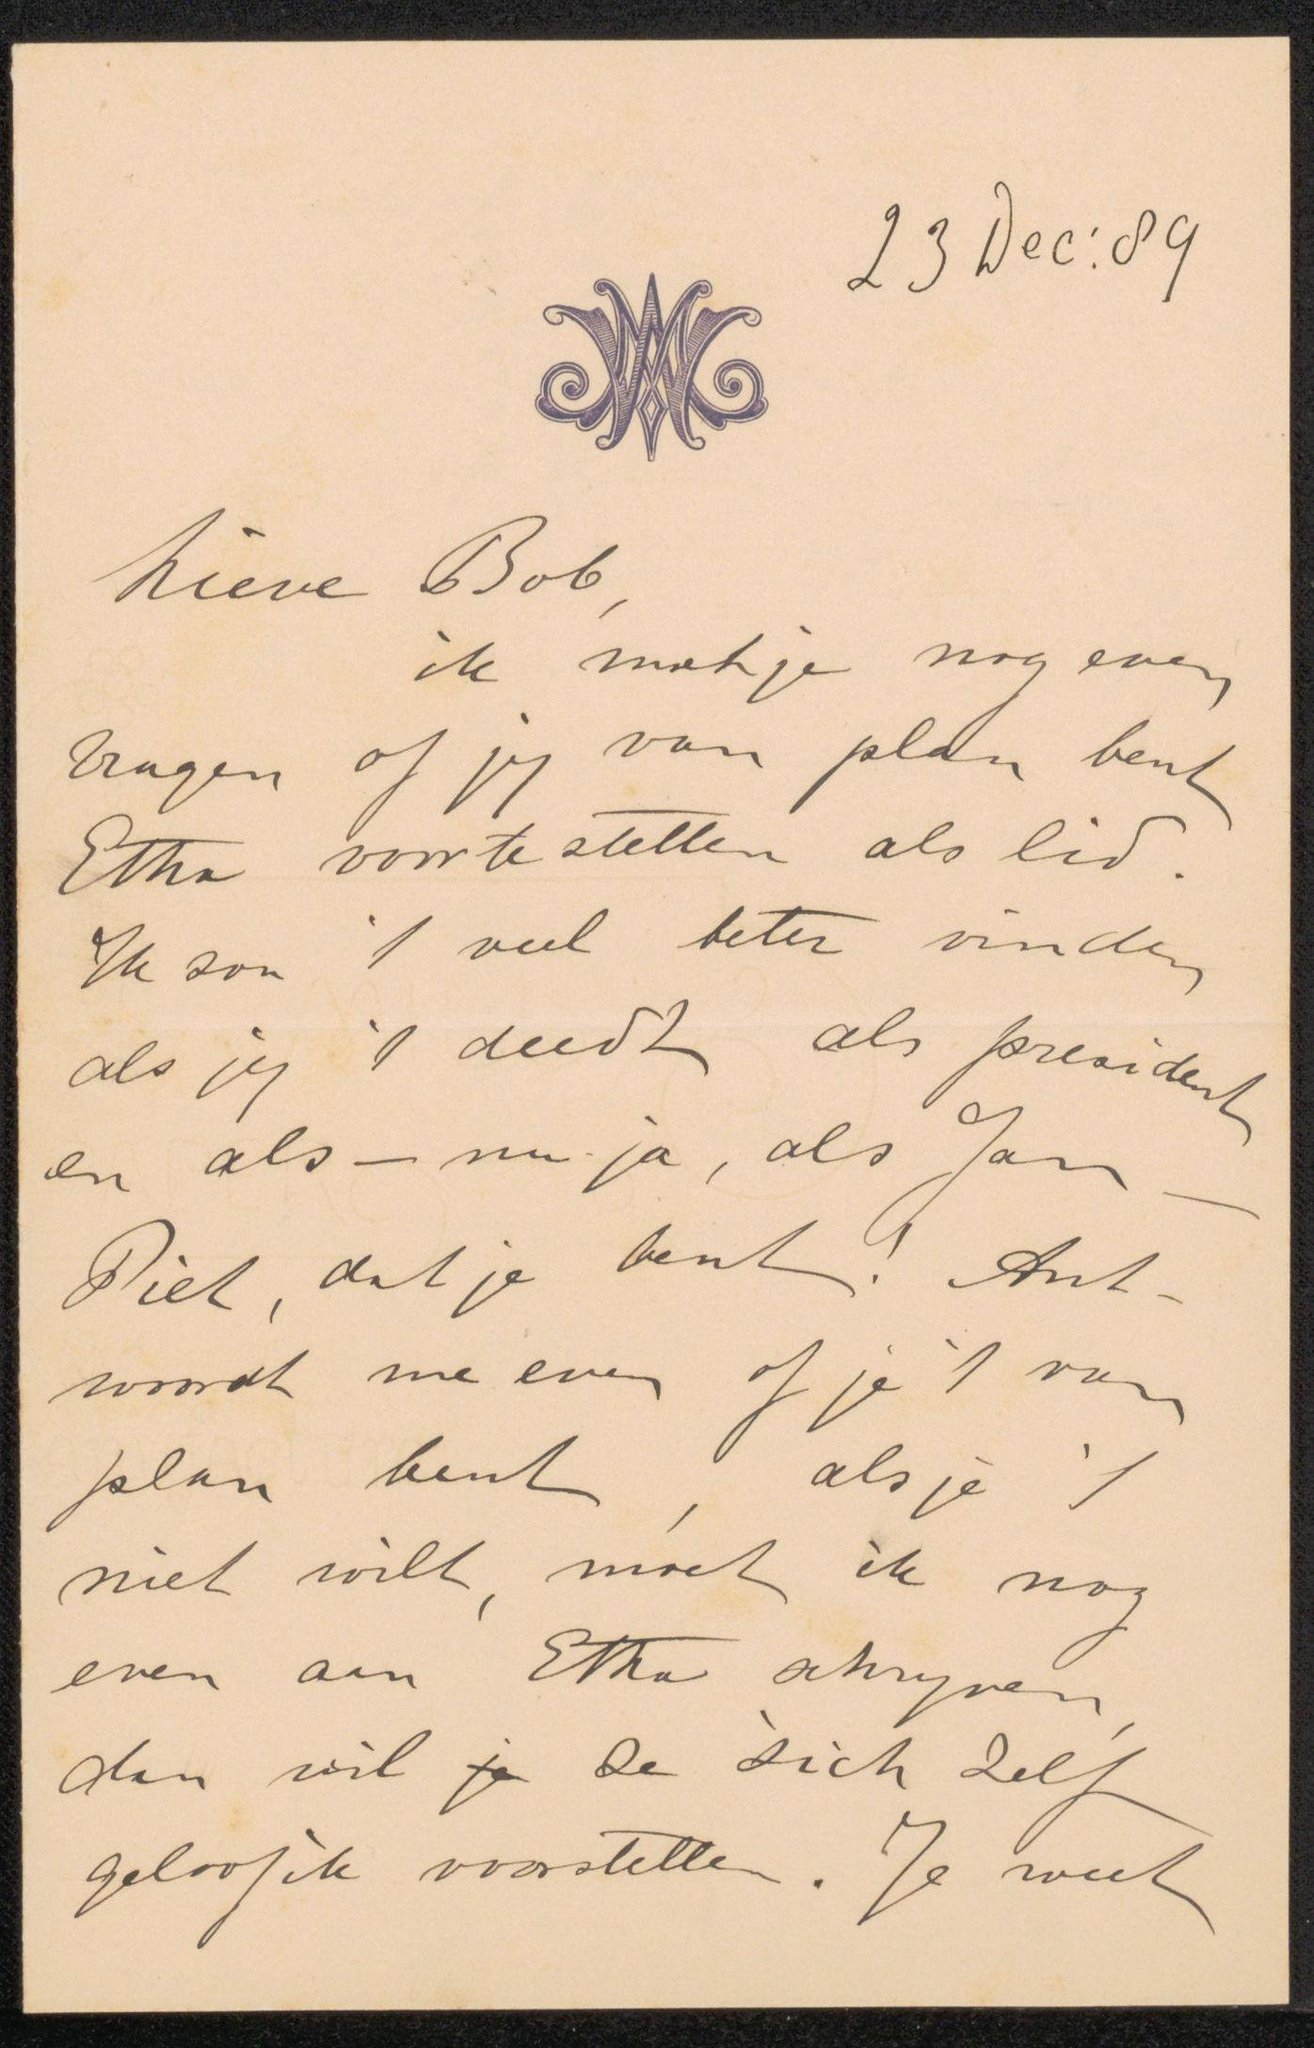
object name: letter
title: Brief aan Jan Veth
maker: wally moes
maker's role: draughtsman, print maker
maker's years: 1856-1918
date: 1874-1918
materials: ink, paper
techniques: pen, writing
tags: dordrecht, painter, designer, jan veth, utrecht, etha fles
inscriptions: collector's mark: ‘RPK’, monogram: ‘WM’, watermark